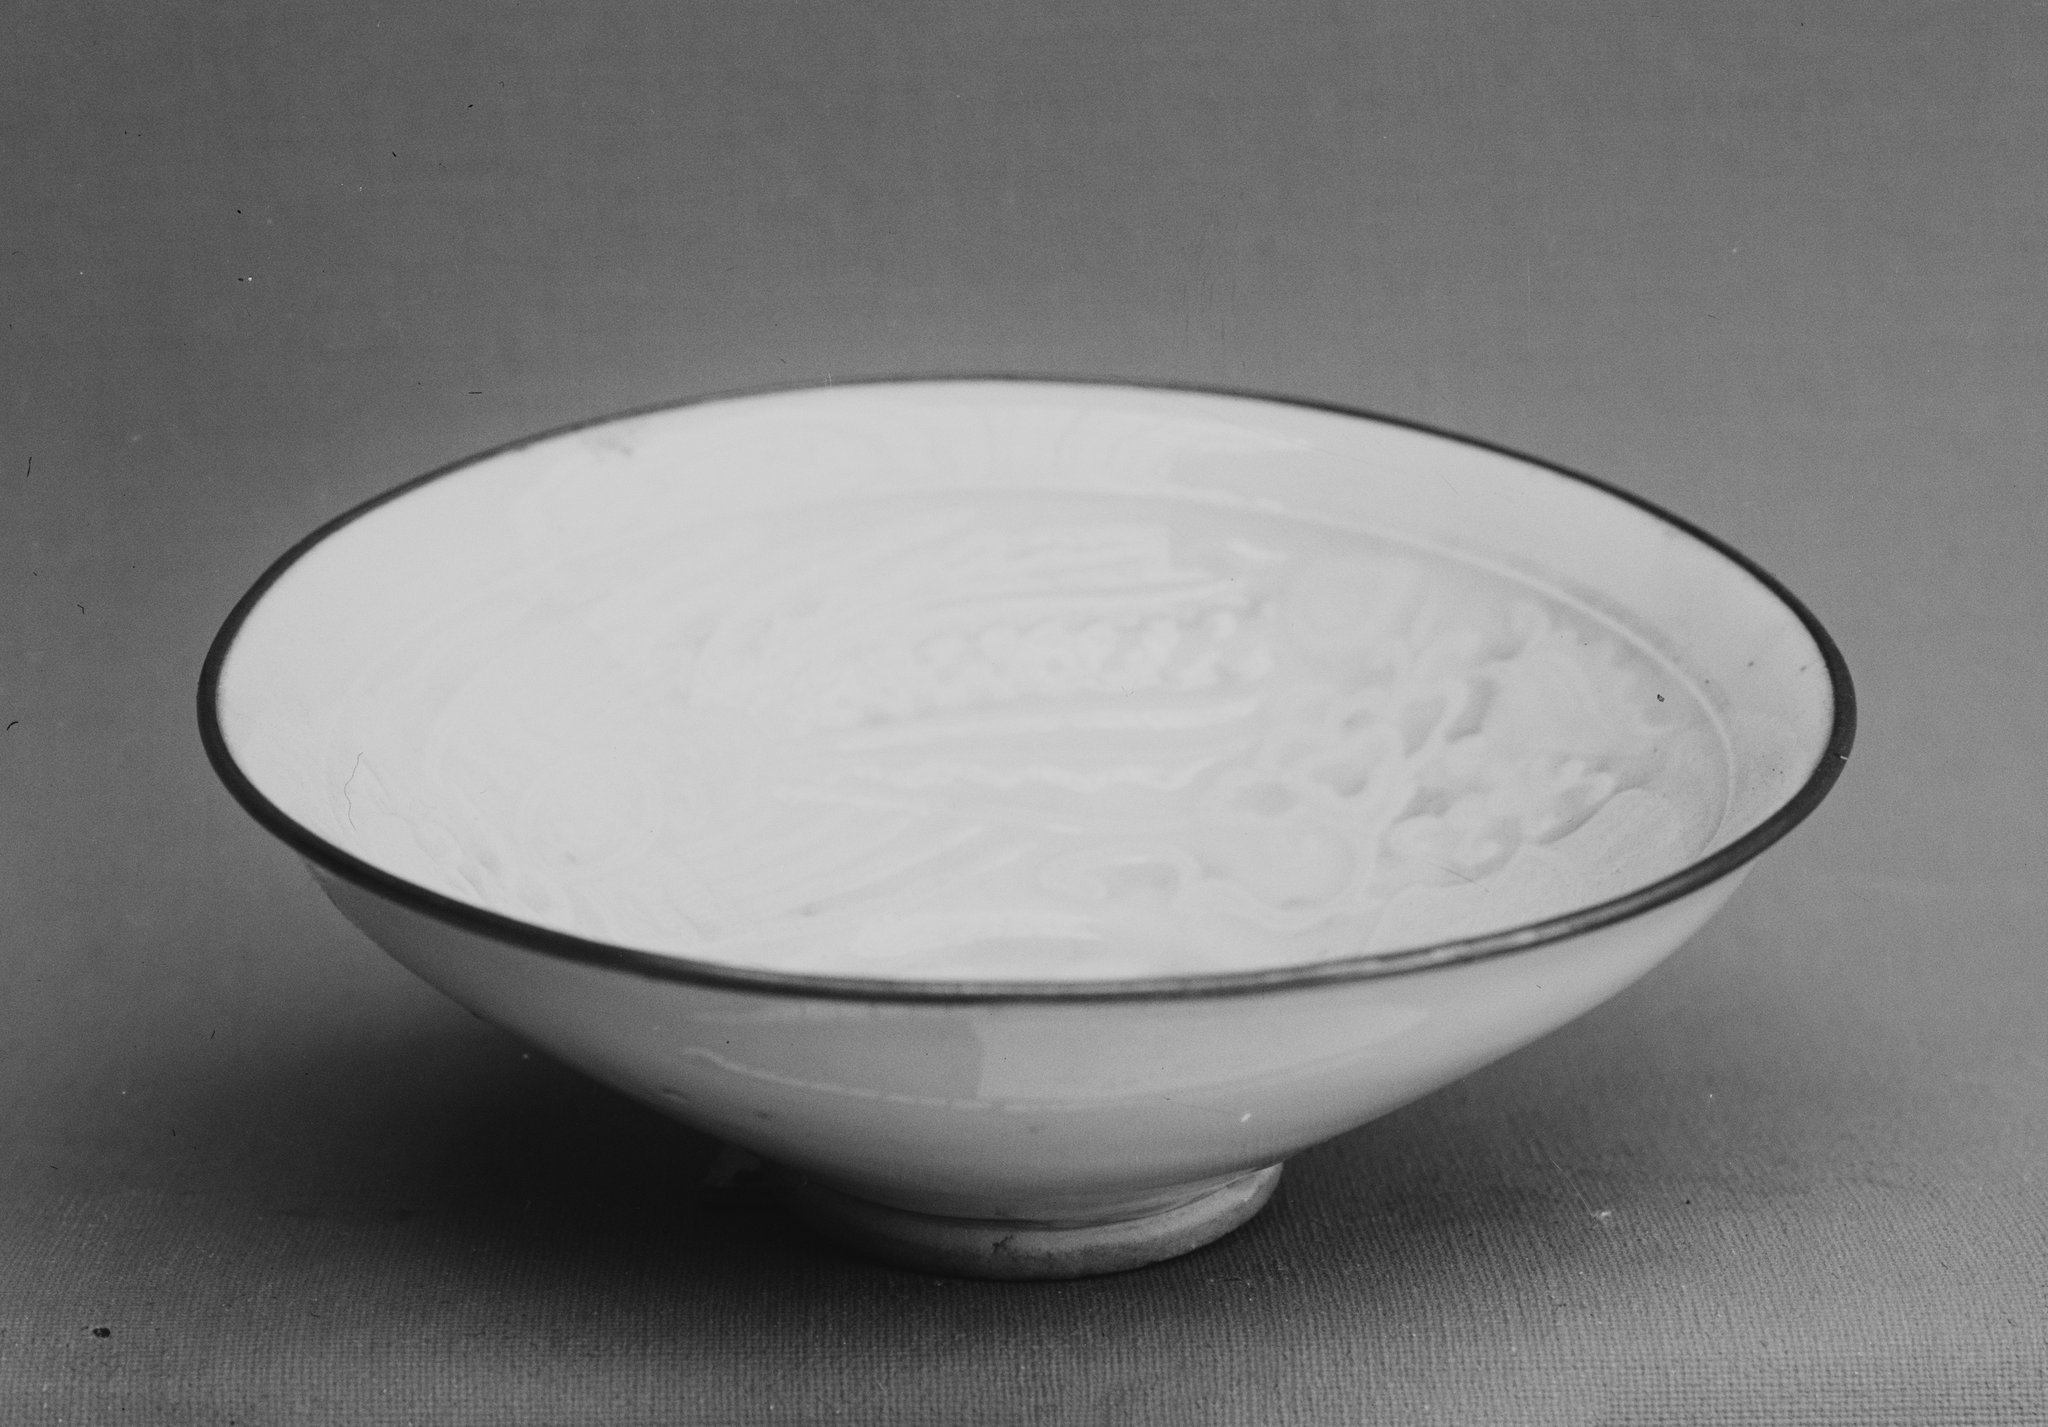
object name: bowl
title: Sacrificial Bowl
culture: japanese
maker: eiraku hozen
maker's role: artist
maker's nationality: japanese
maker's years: 1795-1854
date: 1830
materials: porcelain